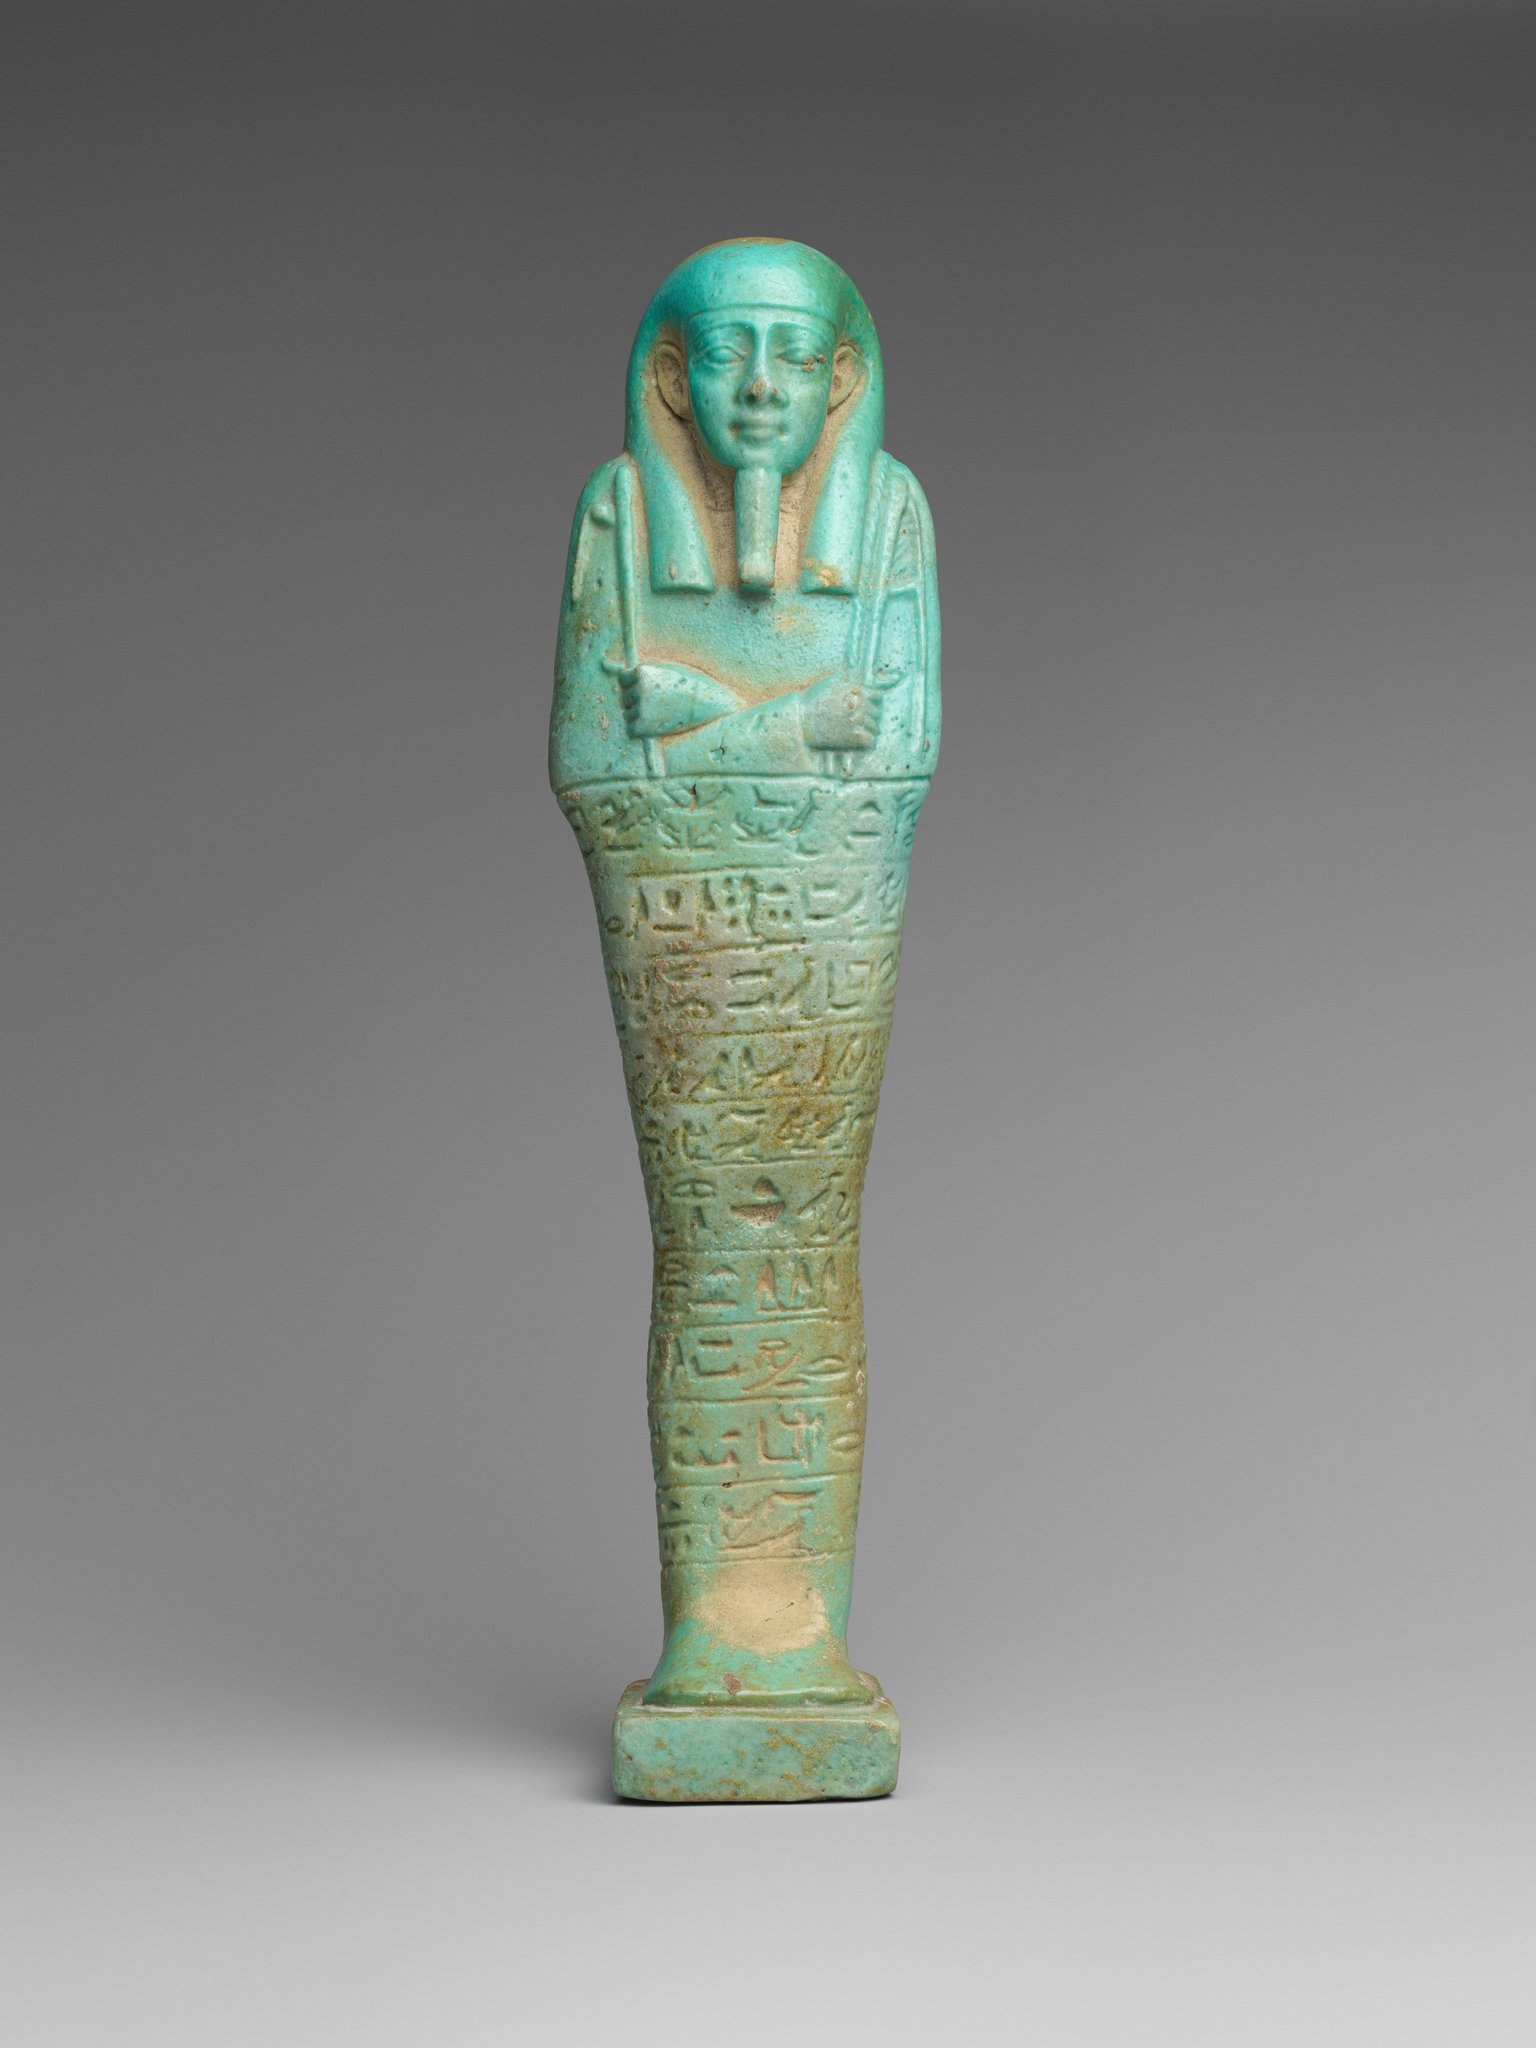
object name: shabti, tjanenhebu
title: Shabti of the Commander of the Royal Fleet Tjanenhebu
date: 570-526 BCE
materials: faience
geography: egypt